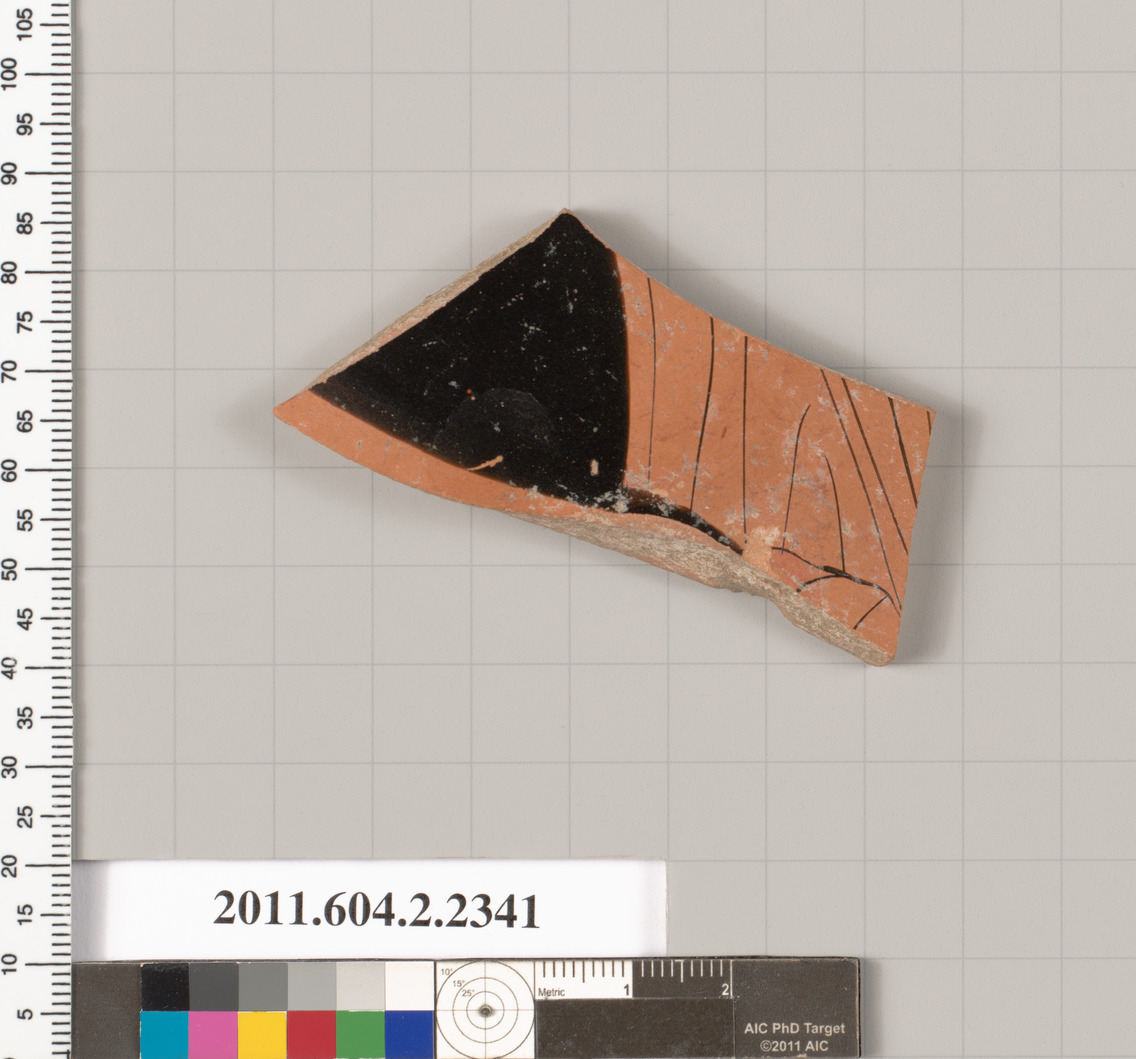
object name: stamnos fragment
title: Terracotta fragment of a stamnos (jar)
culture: greek, attic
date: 475-451 BCE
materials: terracotta